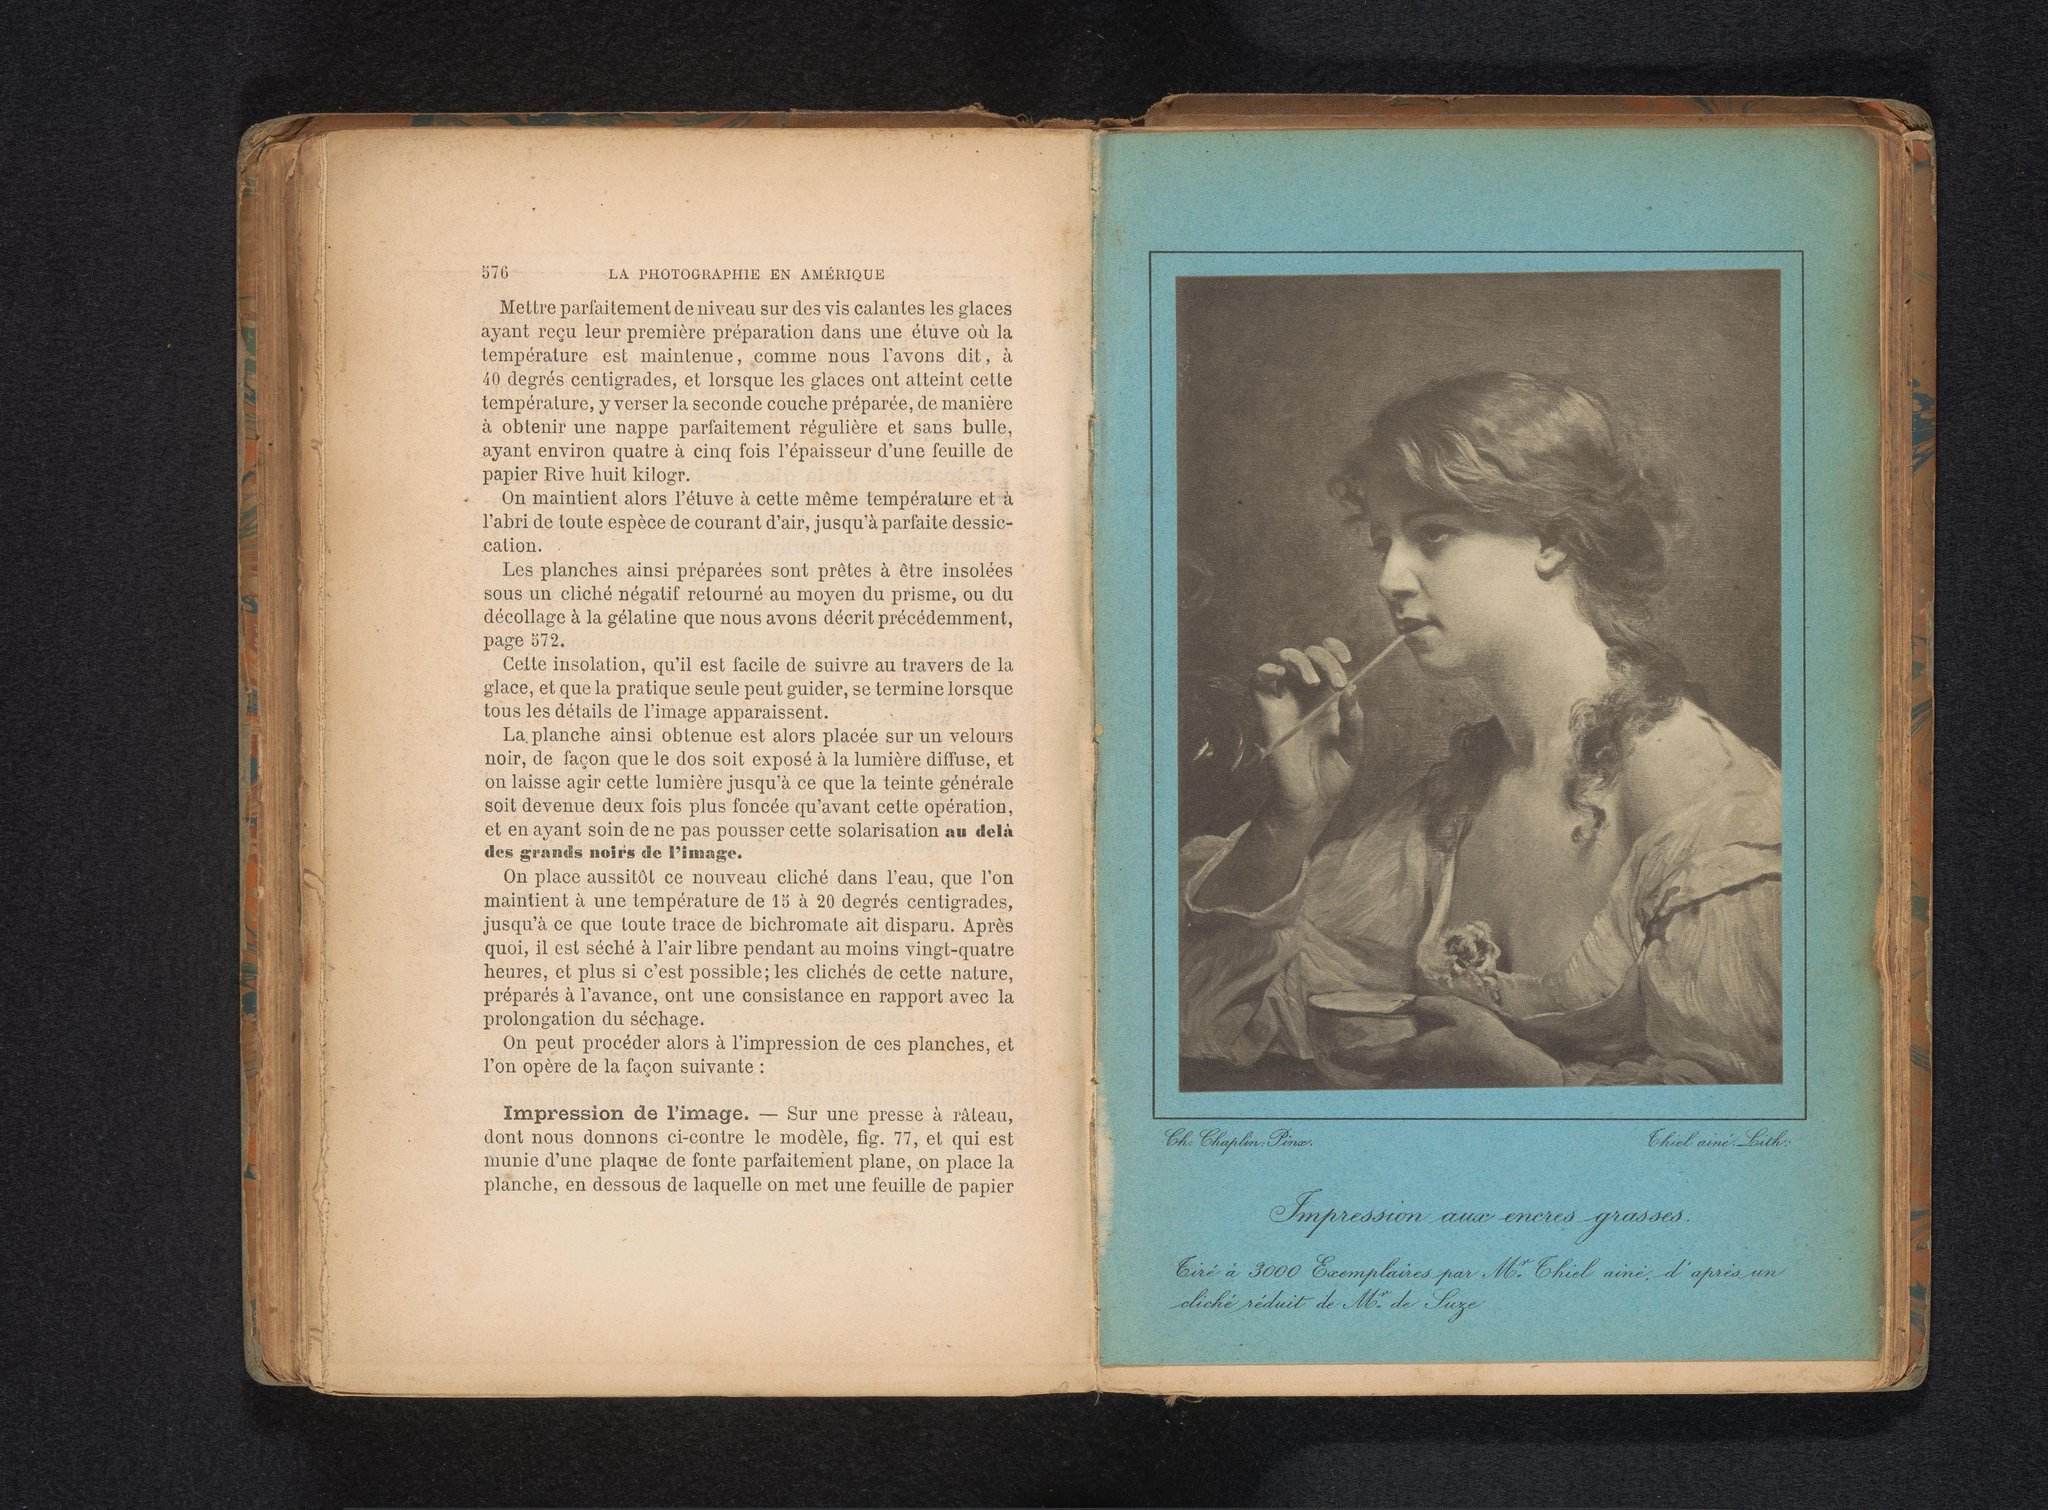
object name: page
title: Reproductie van een schilderij van een onbekende vrouw door Charles Chaplin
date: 1873-1878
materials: paper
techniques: photograph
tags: historical persons not known by name - bb - woman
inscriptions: inscription: ‘Impression aux encres grasses./ Tiré à 3000 Exemplaires par Mr. Chiel ainé, d'après un cliché réduit de Mr. de Luze.’